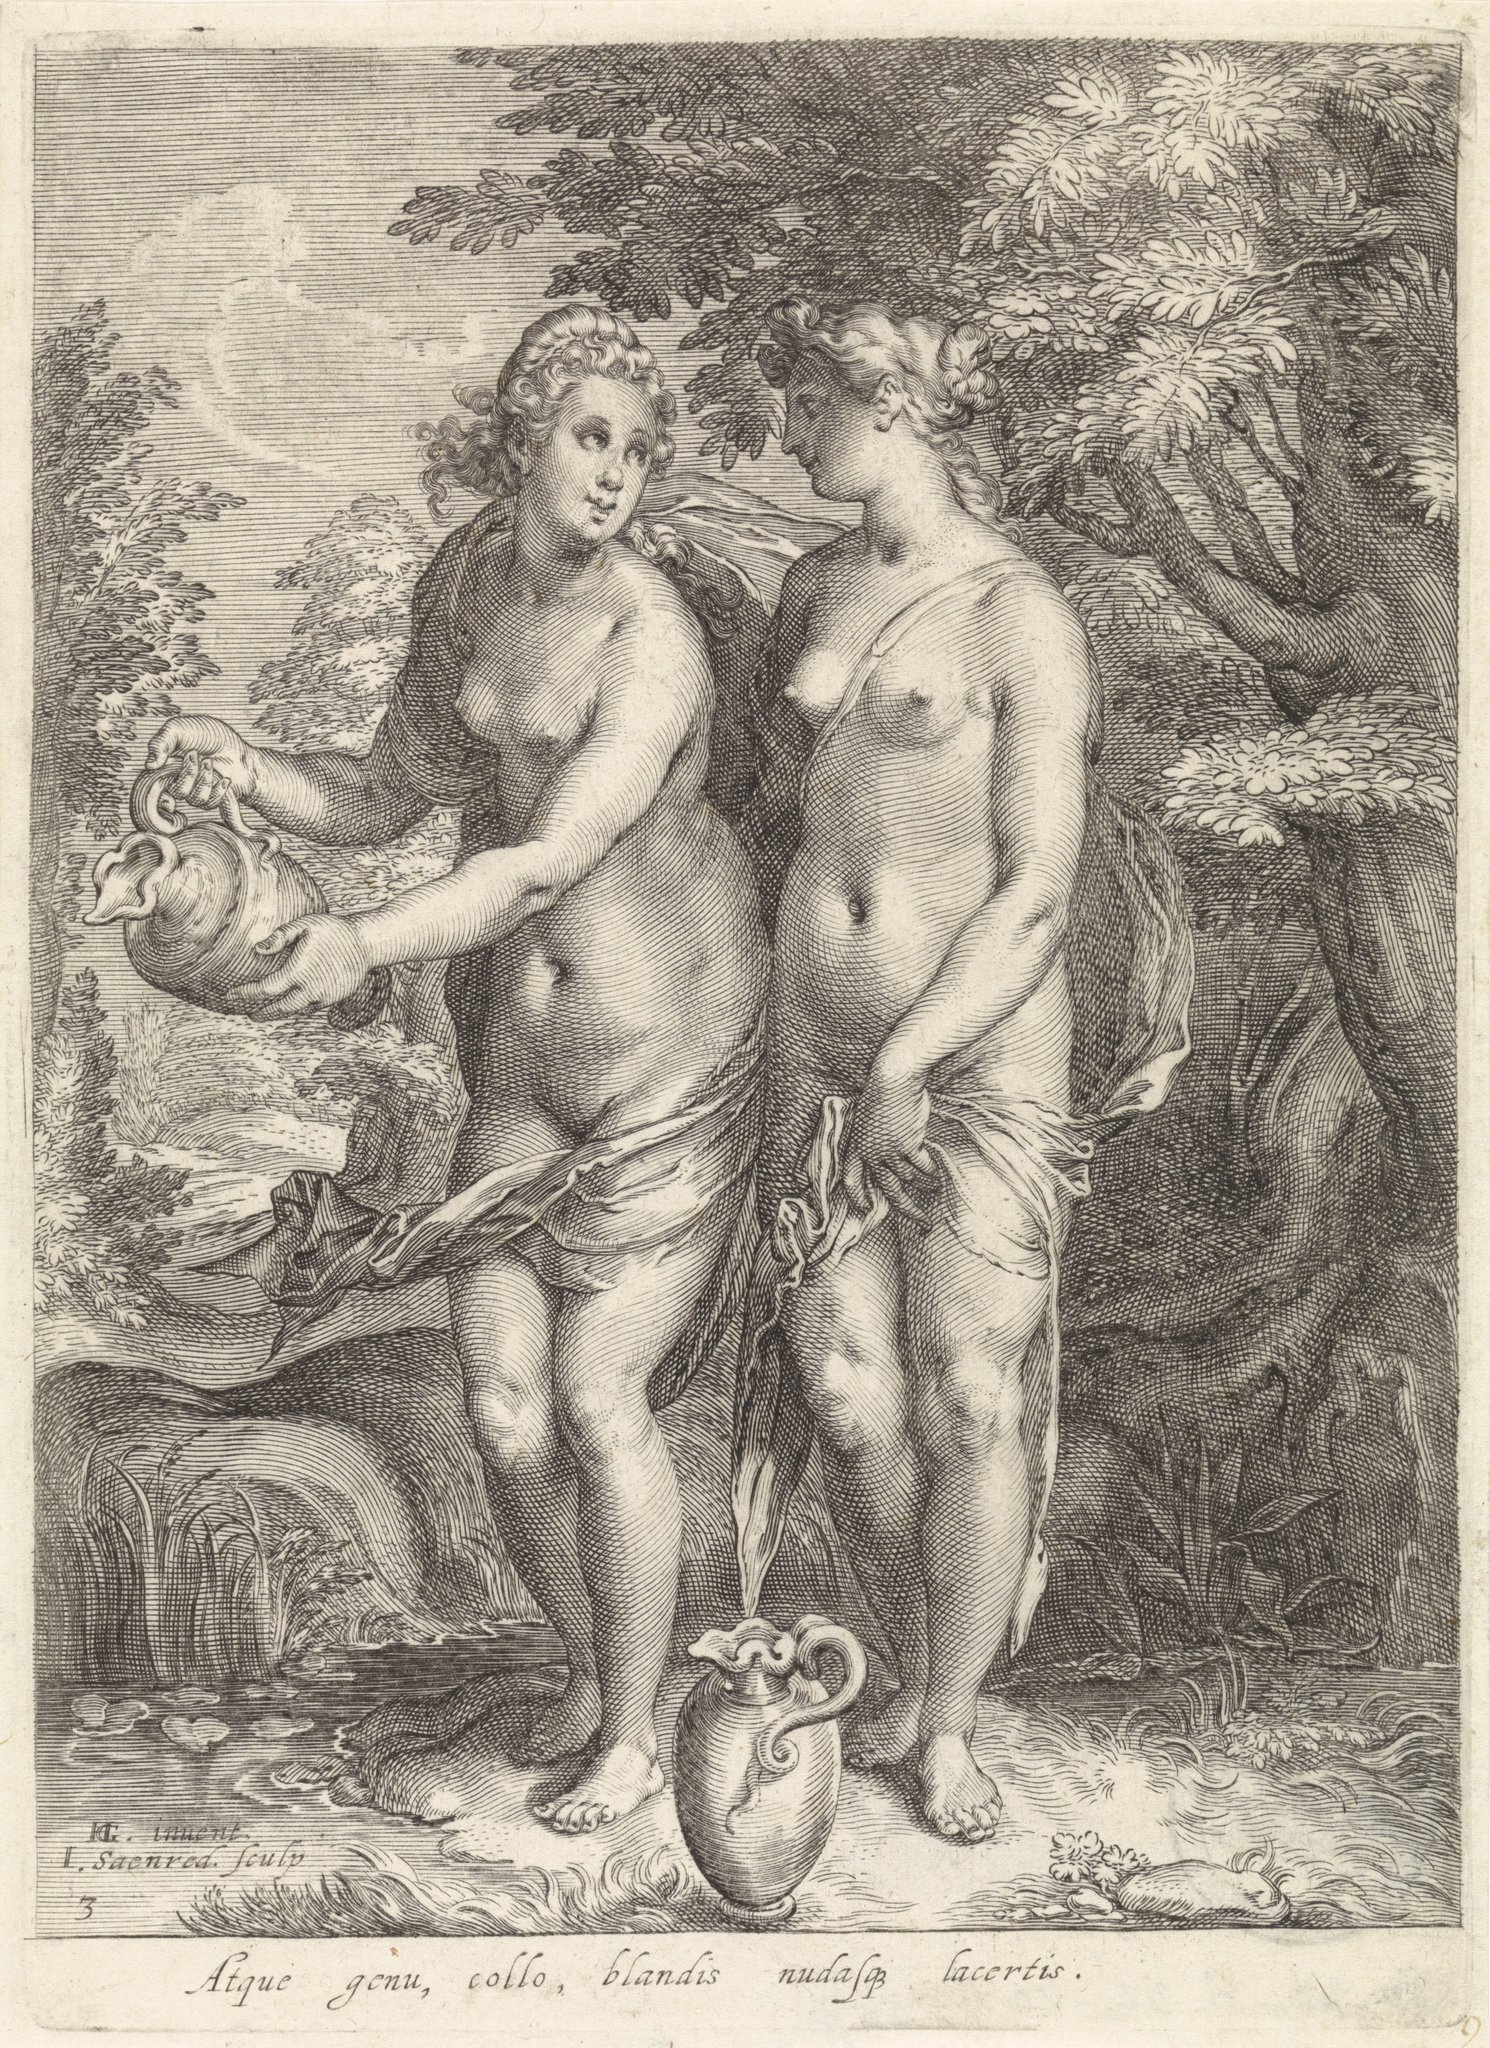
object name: print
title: Diana en haar nimfen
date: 1616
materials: paper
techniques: engraving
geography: assendelft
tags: companions, nymphs of diana; 'ninfe di diana' (ripa), brook, container of ceramics: jar, jug, pot, vase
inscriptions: number: ‘9’, collector's mark: Lugt 10, collector's mark: Lugt 11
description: Twee nimfen uit het gevolg van Diana. Ze staan naast een beekje. Een van de nimfen giet haar waterkruik leeg in de beek. De prent maakt deel uit van een driedelige serie van Diana en haar nimfen en heeft een Latijns onderschrift.